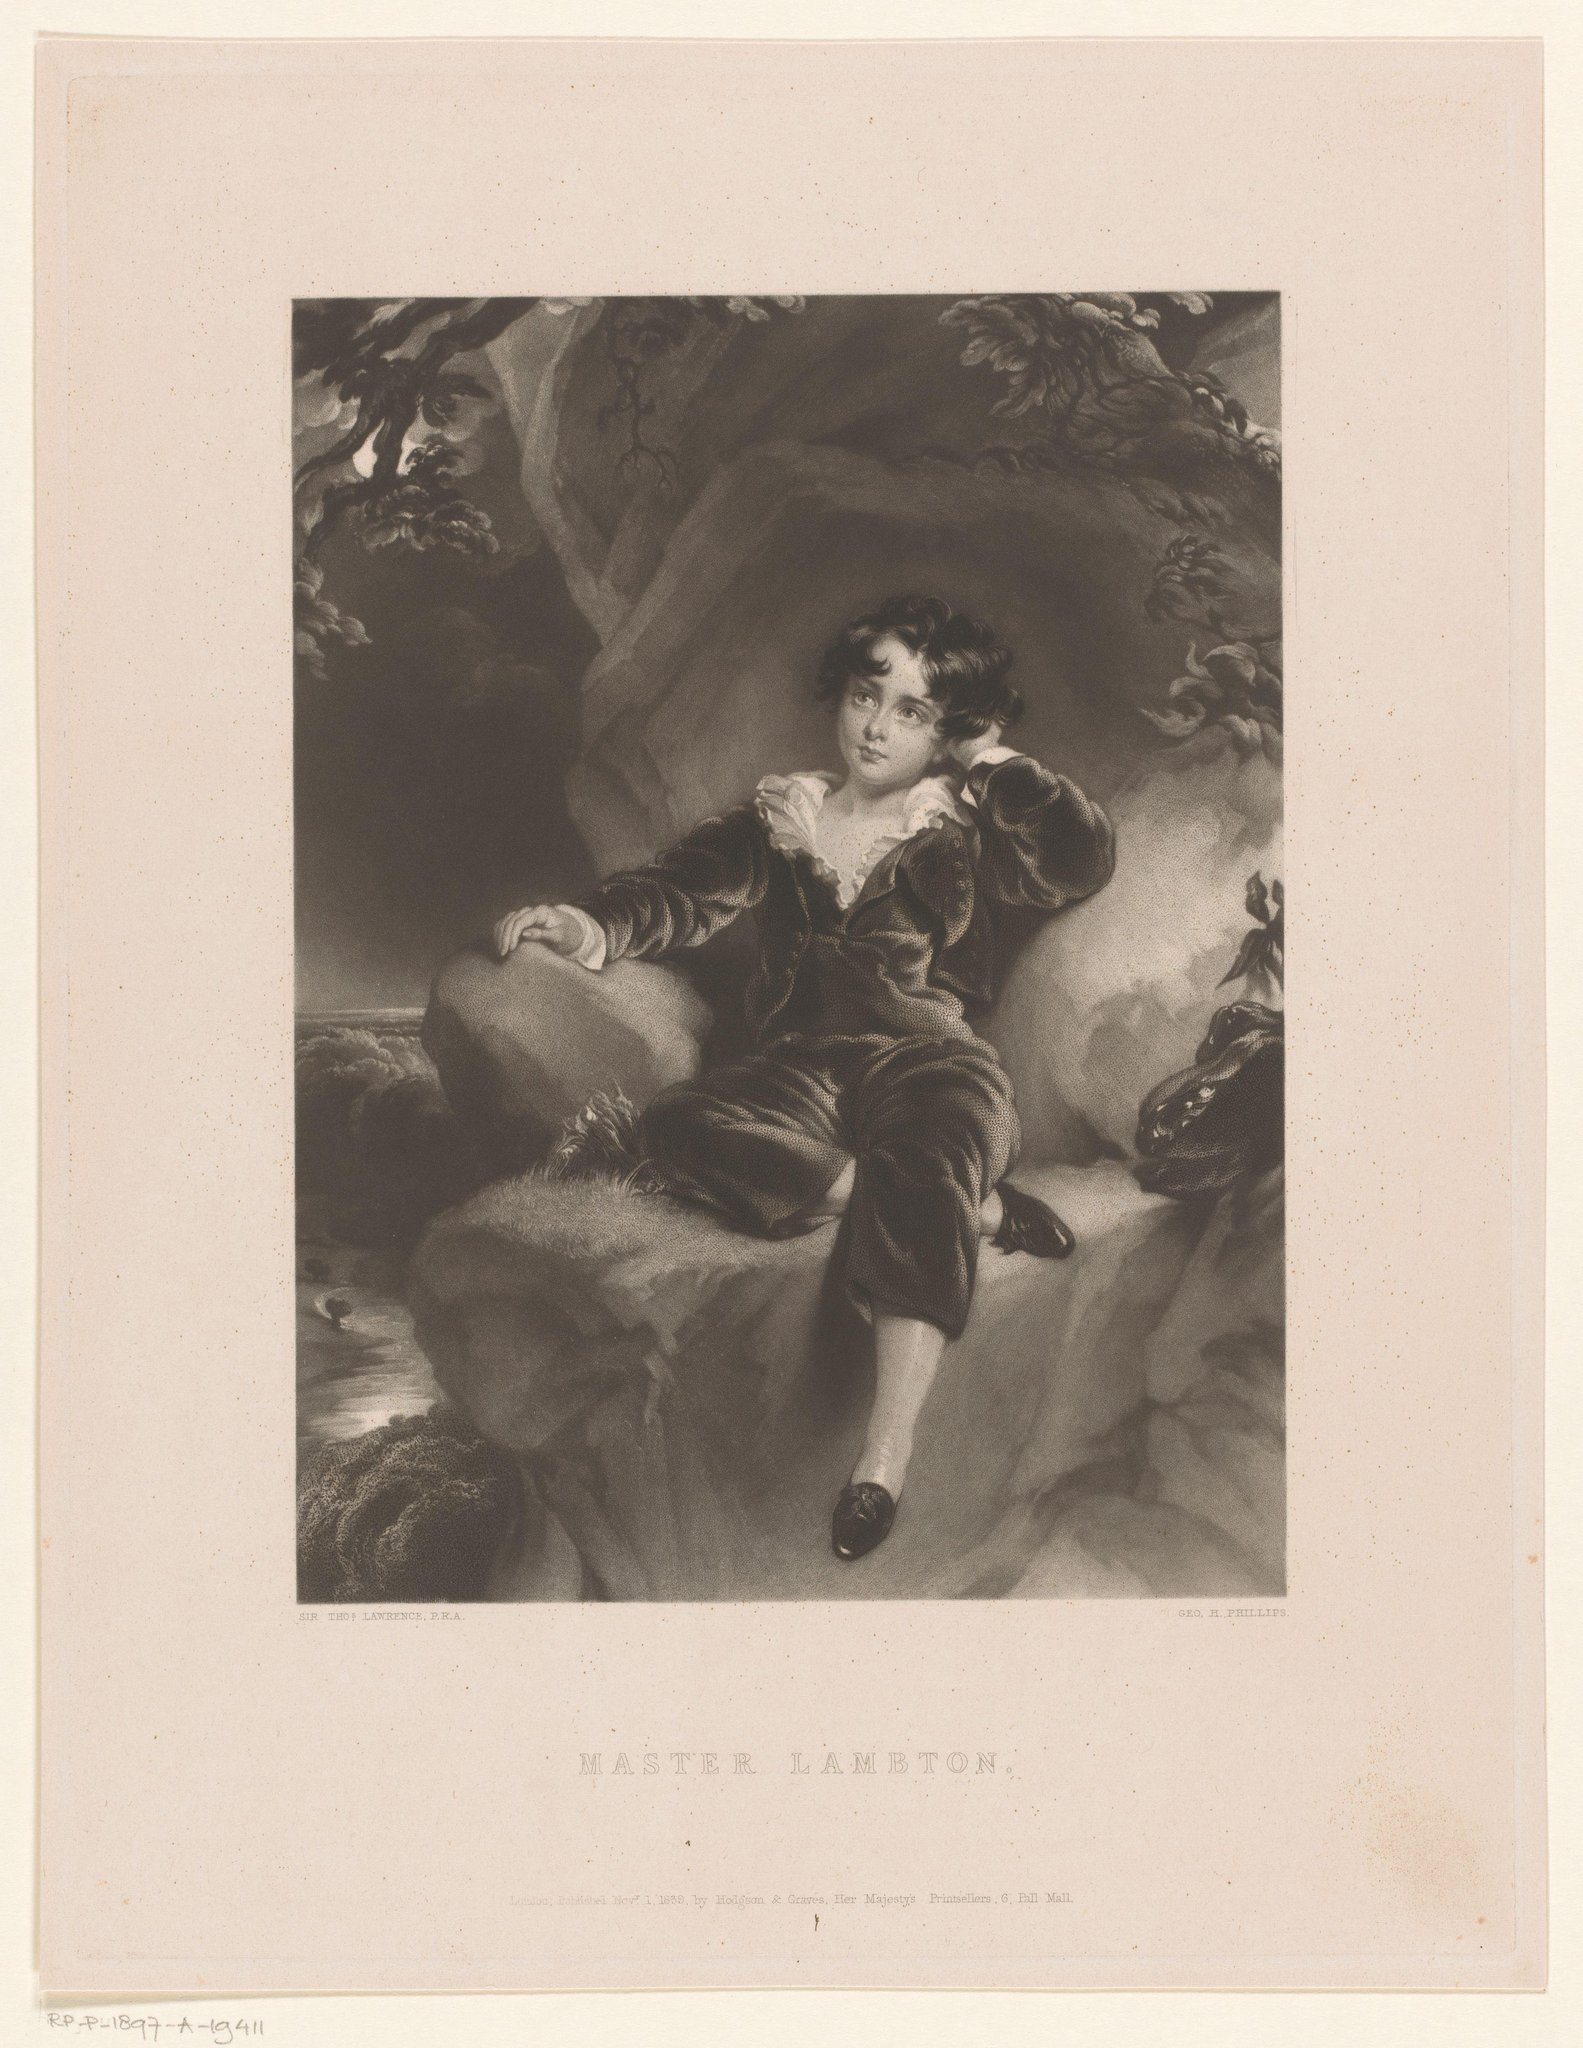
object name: print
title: Portrait of Charles William Lambton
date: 1839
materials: paper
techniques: engraving, etching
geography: london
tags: historical persons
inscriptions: collector's mark: Lugt 2228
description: Lawrence painted this portrait of the seven-year-old Charles William Lambton in 1825. He situated the boy in an unusual setting: a nocturnal, moonlit rocky coastal landscape. In the characteristic pose of a melancholic, his head propped against his hand, the boy stares out dreamily, as a would-be poet. Charles William died of tuberculosis at the age of thirteen.